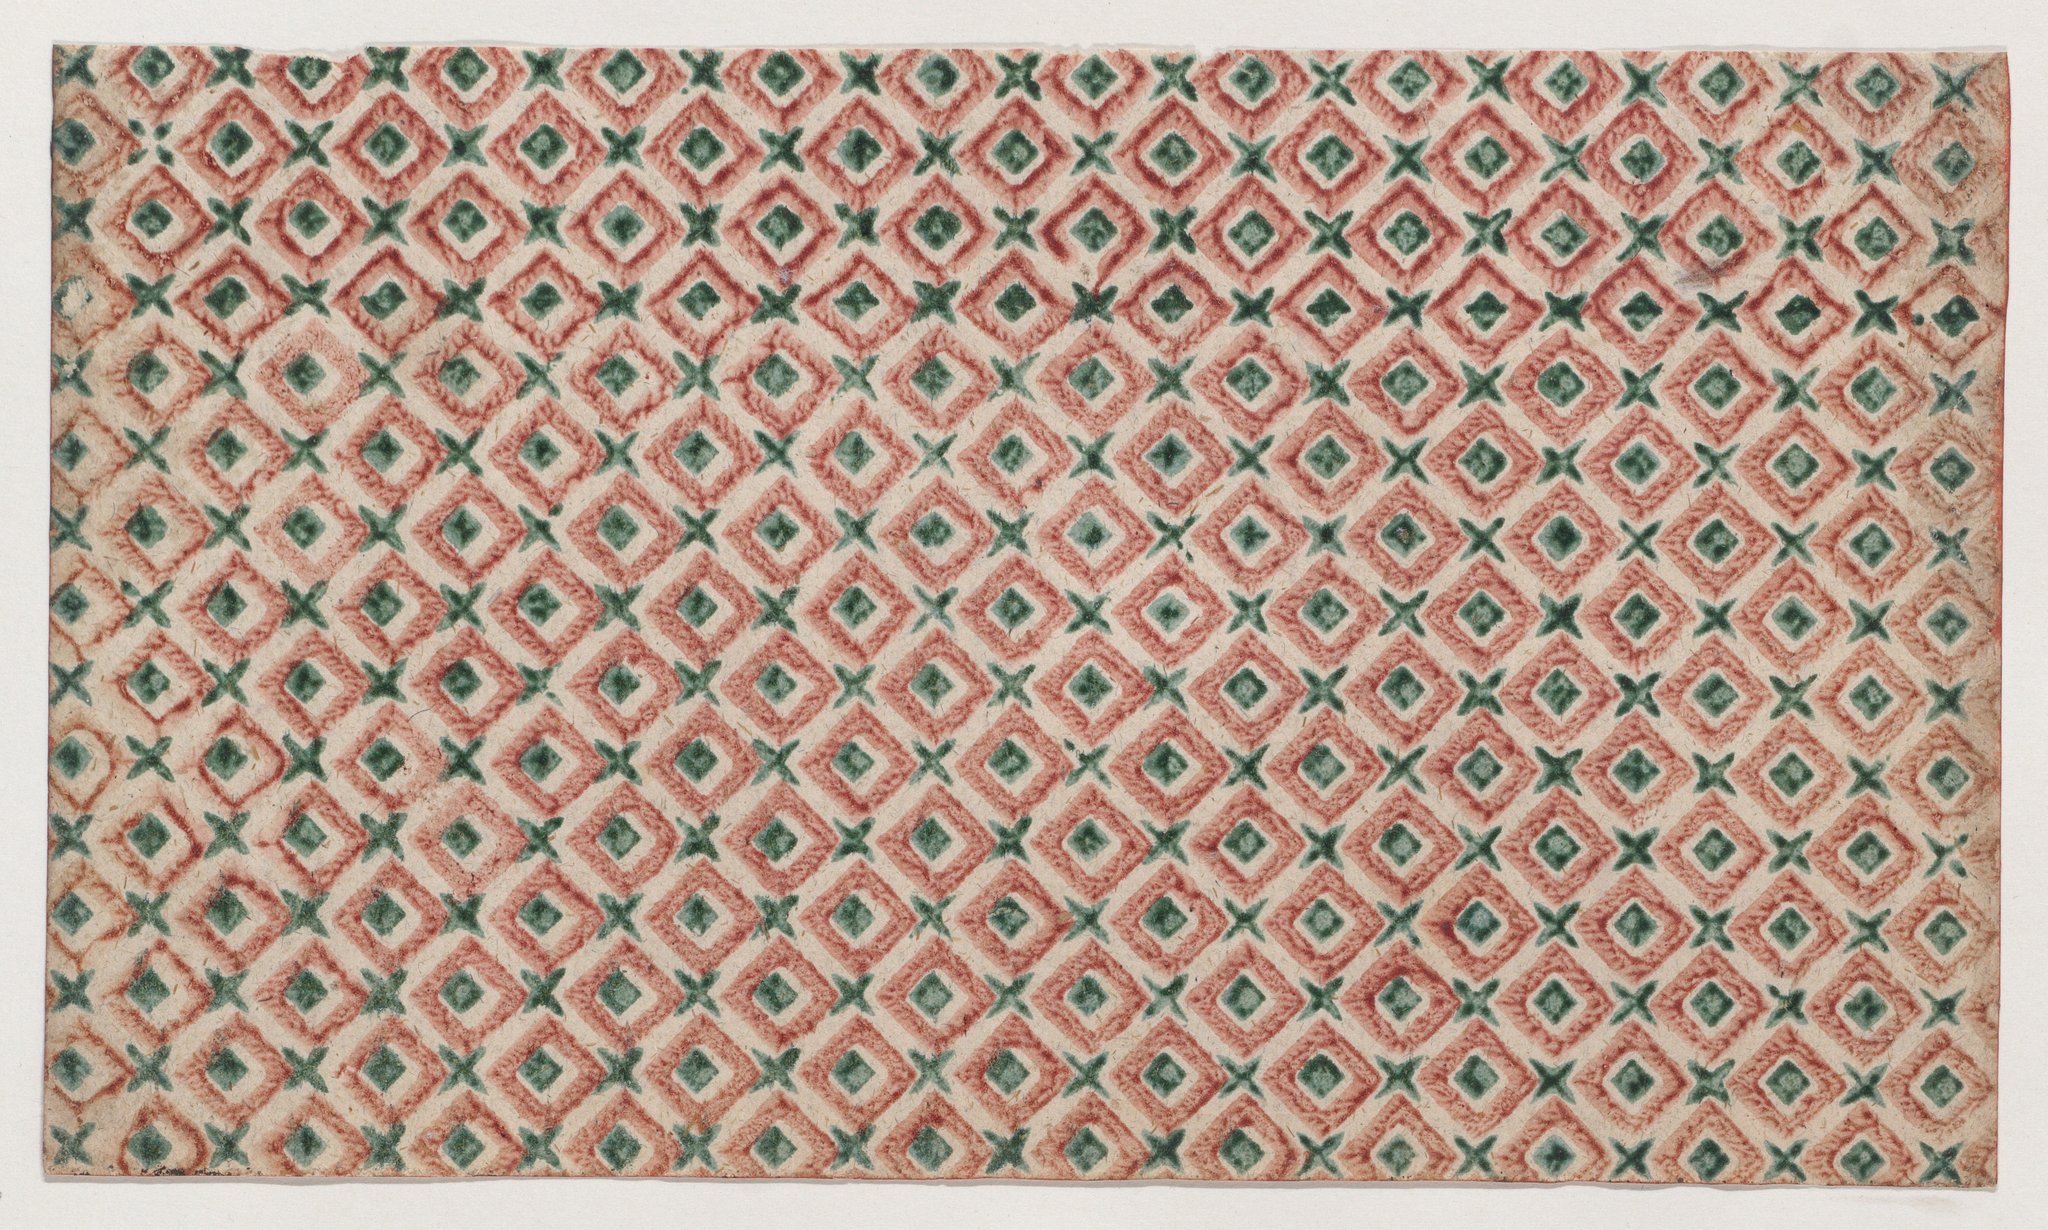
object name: print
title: Sheet with overall pattern of squares and crosses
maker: Anonymous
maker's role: artist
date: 1801-1900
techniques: relief print